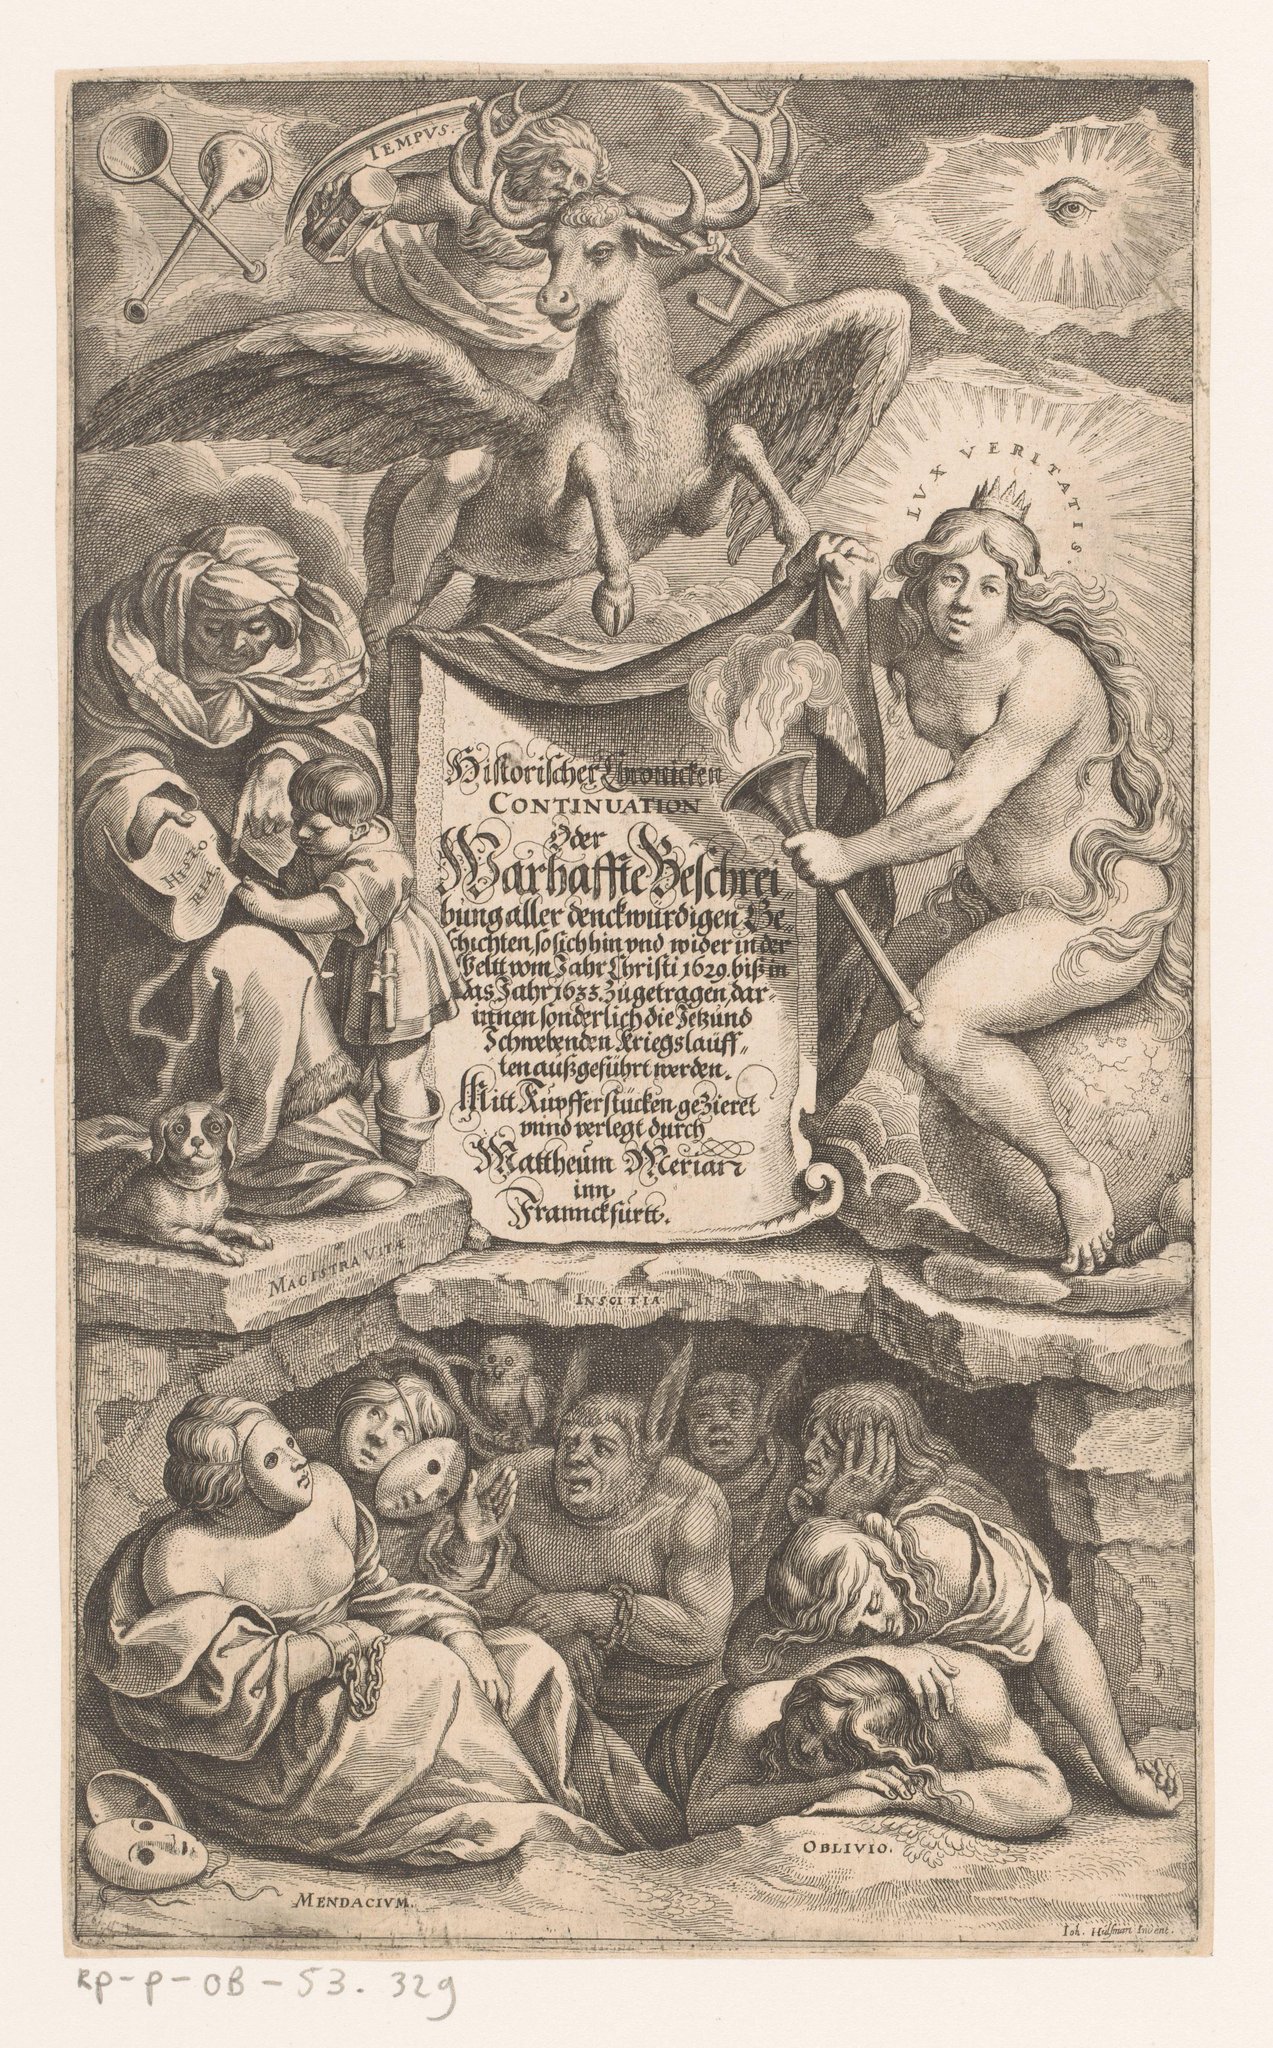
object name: book illustration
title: Historischer Chronicken continuation (...)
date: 1633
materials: paper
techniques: etching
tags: horn, trumpet, cornet, trombone, tuba, title-page, truth; 'verità' (ripa), 'historia'; 'historia' (ripa), the all-seeing eye, triangle with eye ~ symbol of god the father, father time, man with wings and scythe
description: Allegorie op de waarheid. Onderaan vallen de maskers af van zij die de waarheid zien, dat wordt geopenbaard door tijd, verlichting en geschiedenis.